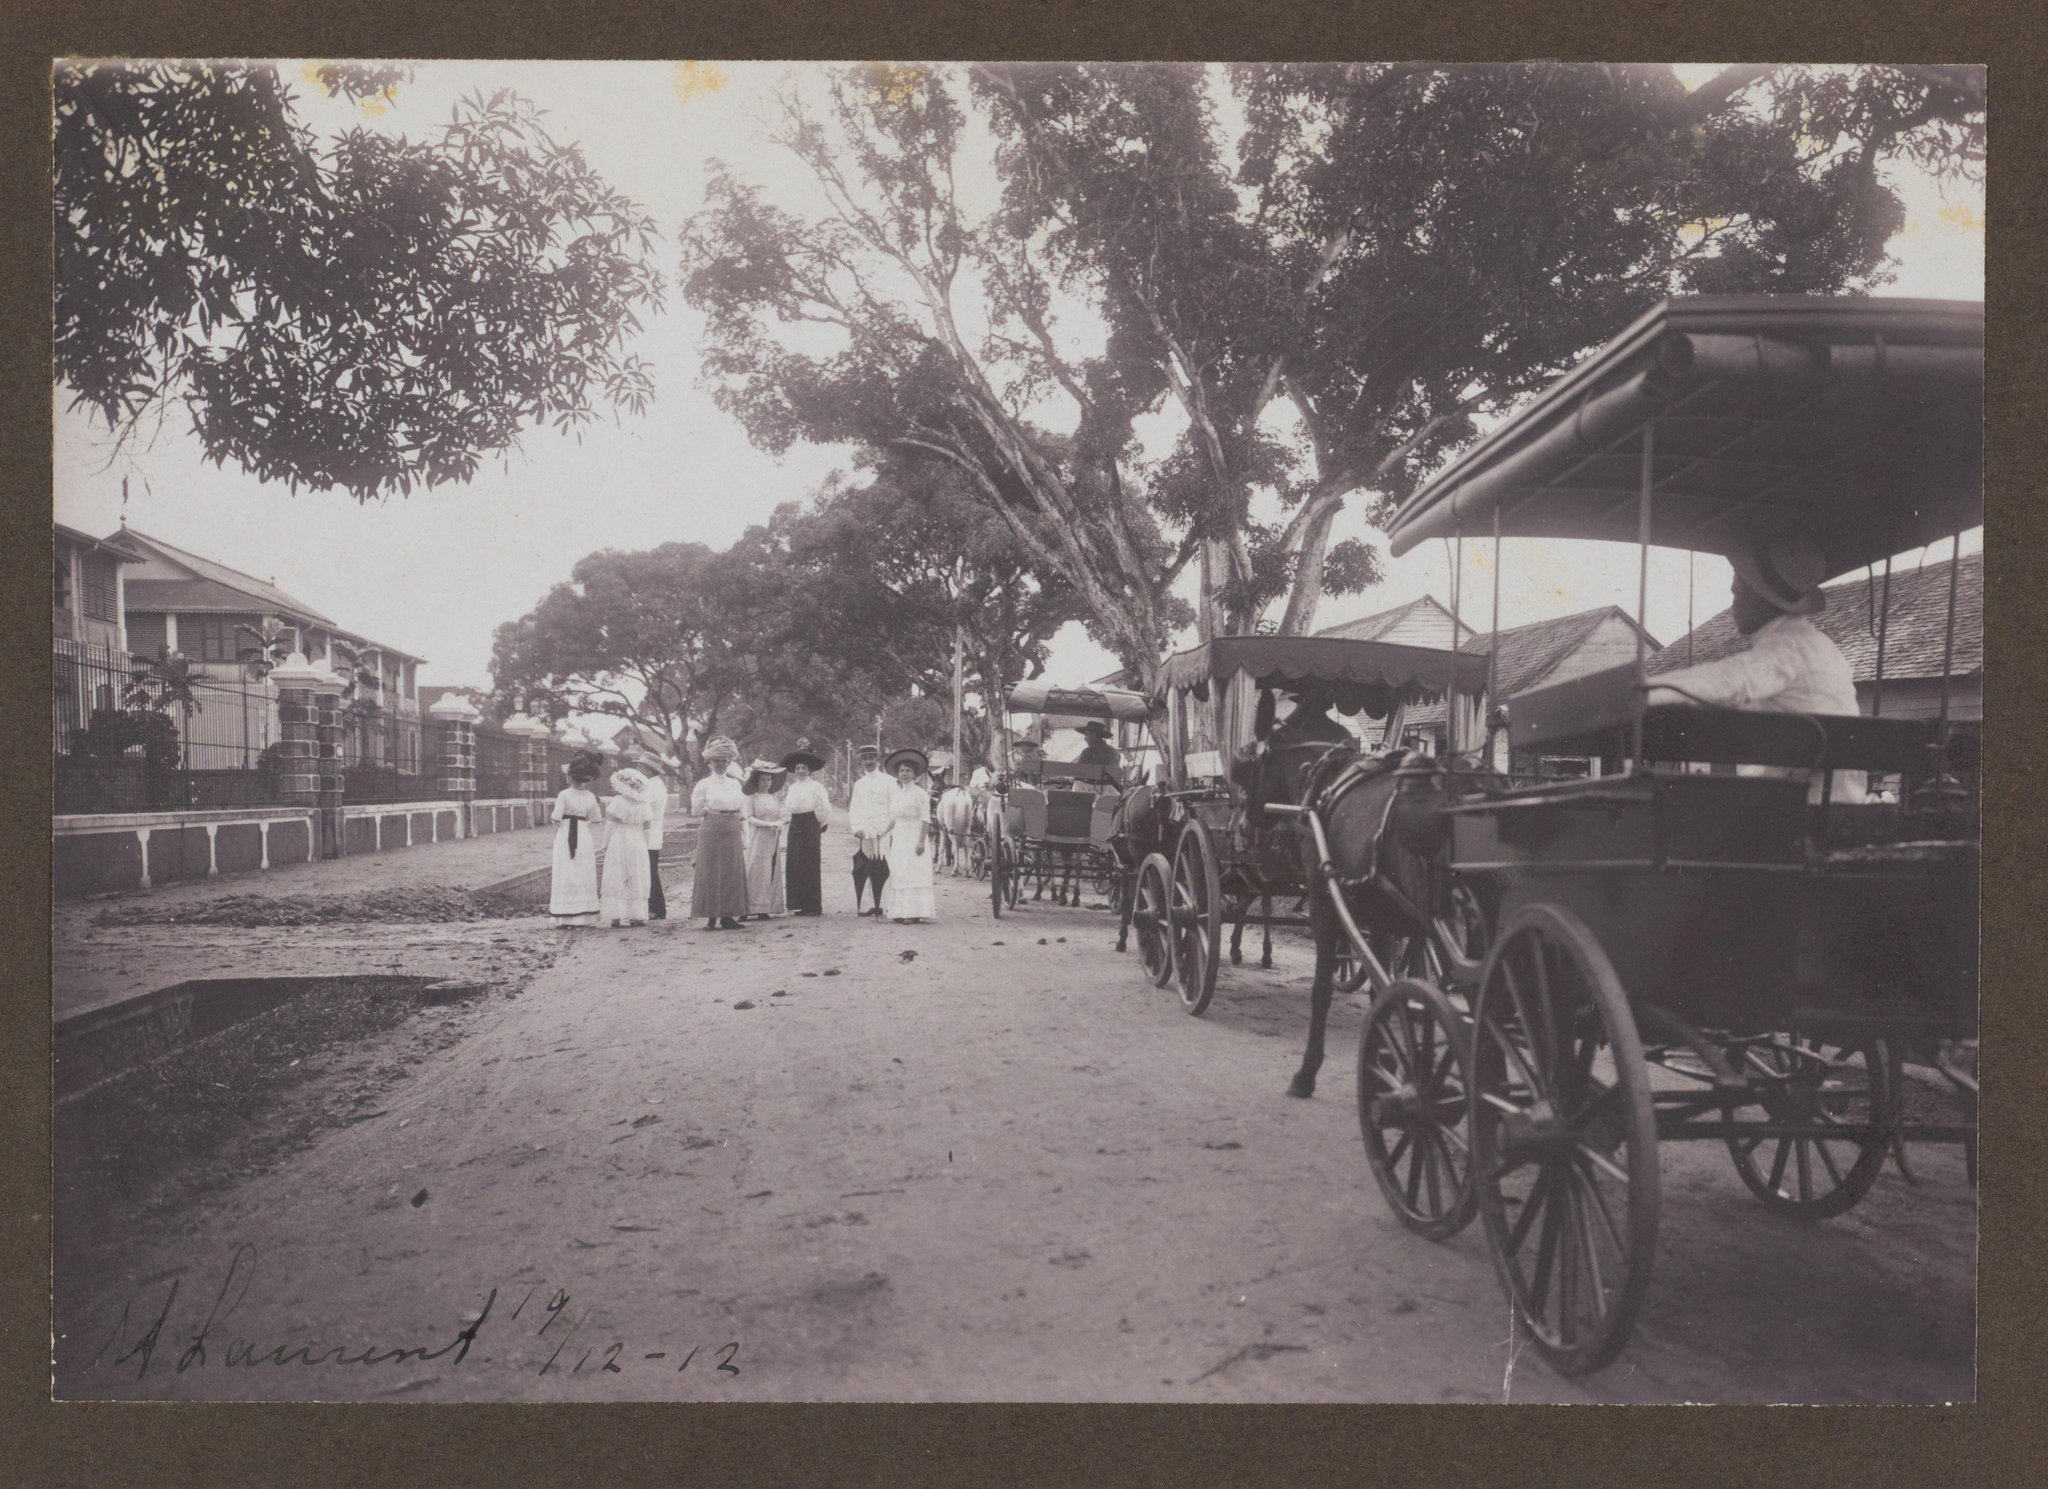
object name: photograph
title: In Saint-Laurent-du-Maroni in Frans Guyana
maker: Anonymous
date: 1912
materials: photographic support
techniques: photography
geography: suriname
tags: city-view in general; 'veduta'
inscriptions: inscription: ‘St. Laurent 19/12-12’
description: Leden van de familie Gonggrijp en vrienden wandelend door een straat in Saint-Laurent-du-Maroni in Frans Guyana, aan de grens met Suriname. Tijdens een bezoek aan het dorp door de familie Gonggrijp op 18-19 december 1912. Onderdeel van een groep van elf albumbladen met familiefoto's van de familie Gonggrijp in Suriname, ca. 1912.